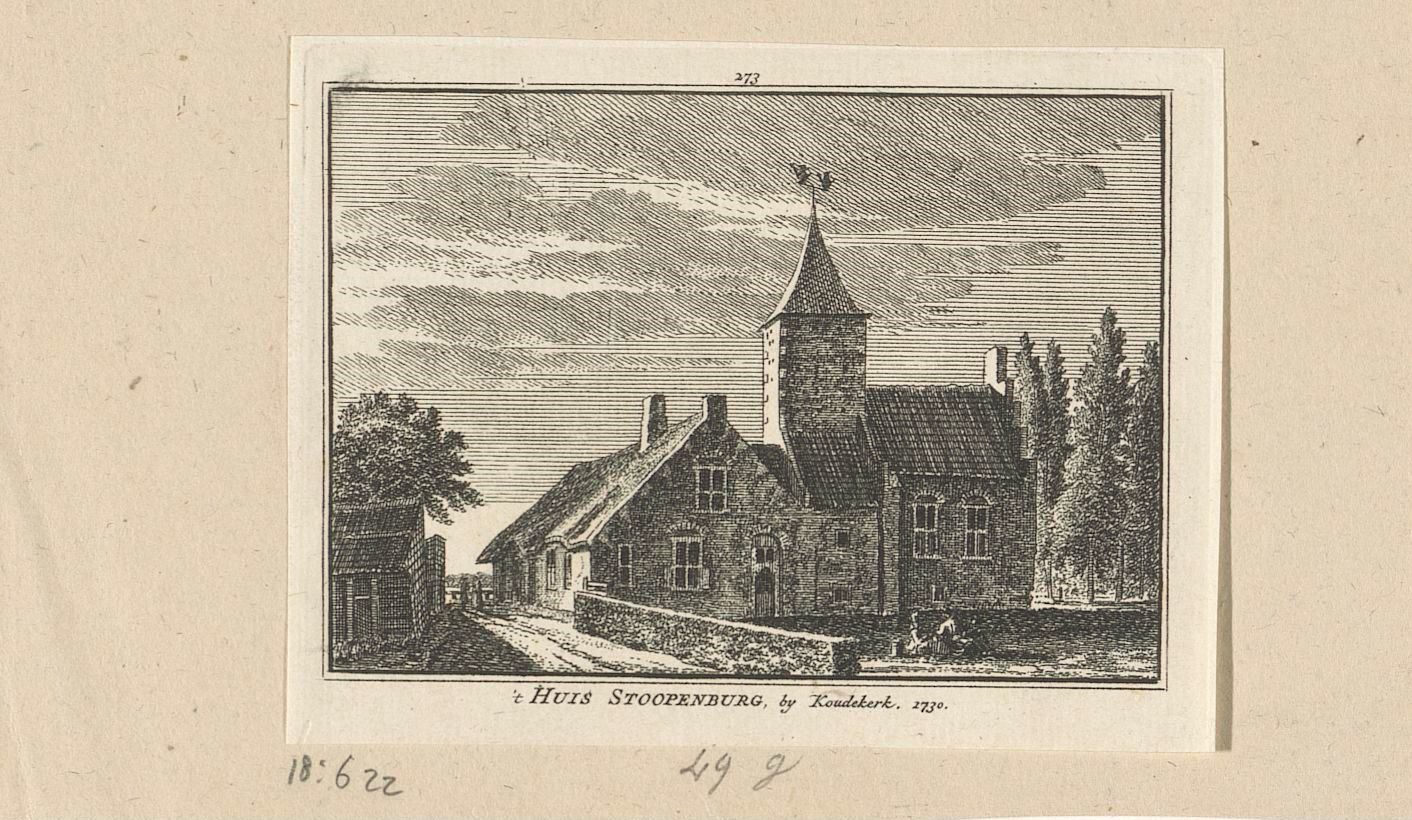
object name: print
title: Gezicht op Huis Stoopenburg, 1730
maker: hendrik spilman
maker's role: draughtsman, painter, print maker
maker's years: 1721-1784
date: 1750-1792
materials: paper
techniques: engraving, etching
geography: haarlem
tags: farm (building), country-house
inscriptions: collector's mark: Lugt 2228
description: Prent ook gebruikt in: Het verheerlykt Nederland of kabinet van hedendaagsche gezigten van steden, dorpen (…). 9 delen. Amsterdam: Isaak Tirion en weduwe Isaak Tirion, 1745-1774, dl. 3 (1750), ill. 273. Of in: Nederlandsche tafereelen; of eene keurige verzameling van negen honderd fraaije gezigten van steden, dorpen, sloten, oudheden (….). 9 delen. Amsterdam: Jan de Groot, 1792, dl. 3, ill. 273.